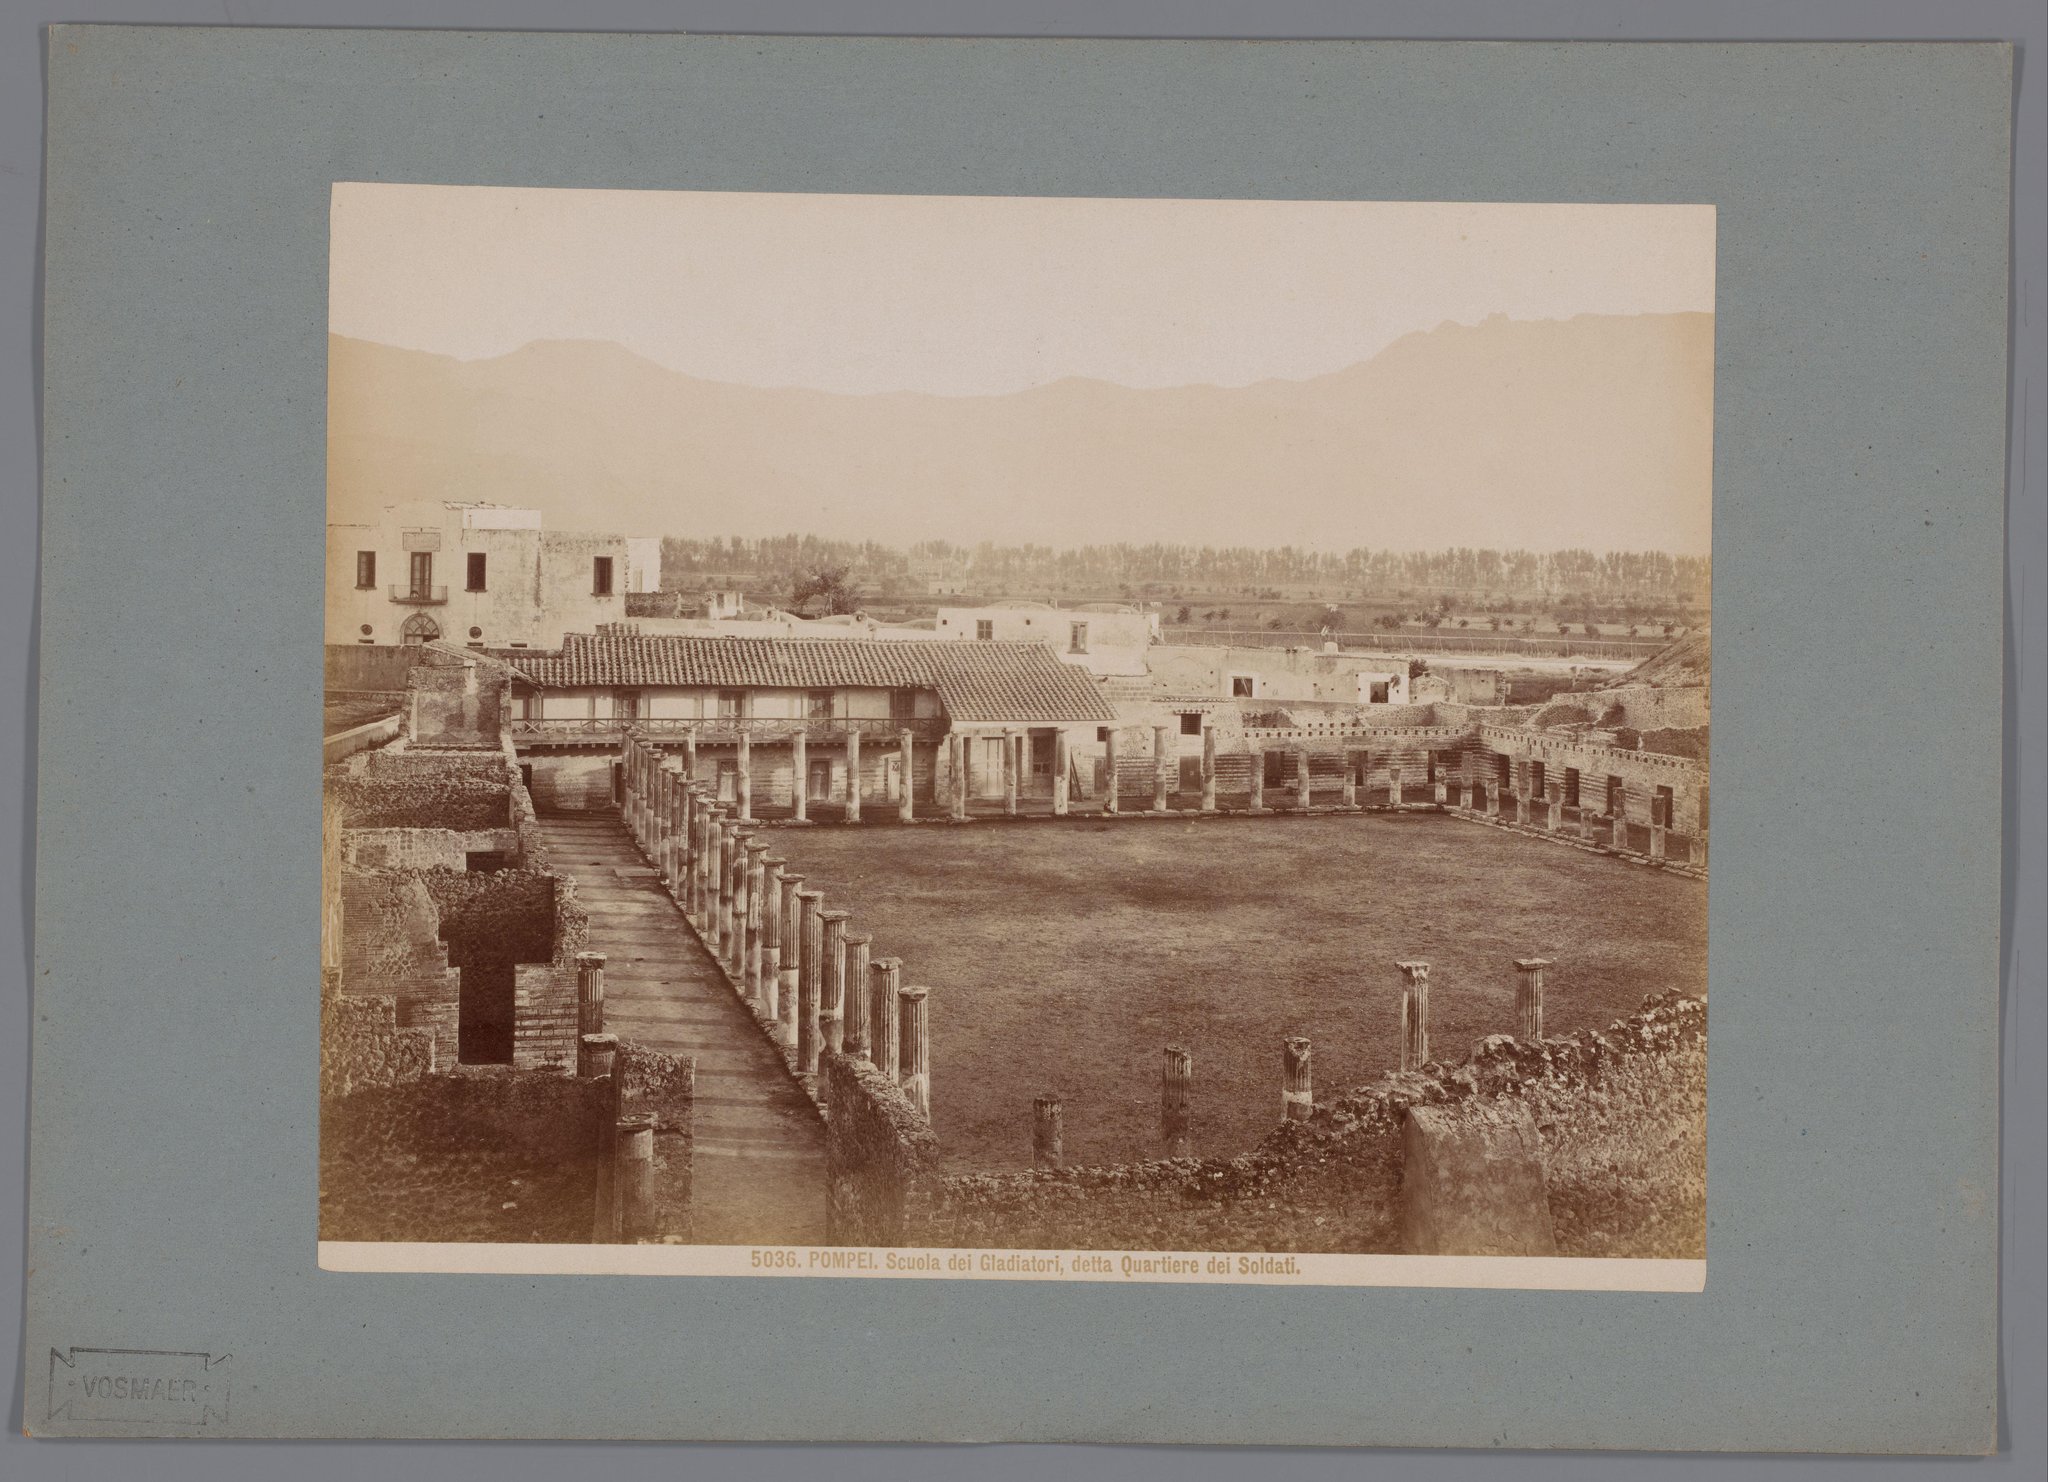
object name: photograph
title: Scuola dei Gladiatori, detta Quartiere dei Soldati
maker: giacomo brogi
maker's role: fotograaf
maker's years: 1822-1881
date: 1864-1881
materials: cardboard, paper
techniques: albumen print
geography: pompeii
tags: ruin of a building ~ architecture, landscape with ruins, pompeii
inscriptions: collector's mark: ‘VOSMAER’, number: ‘5036.’